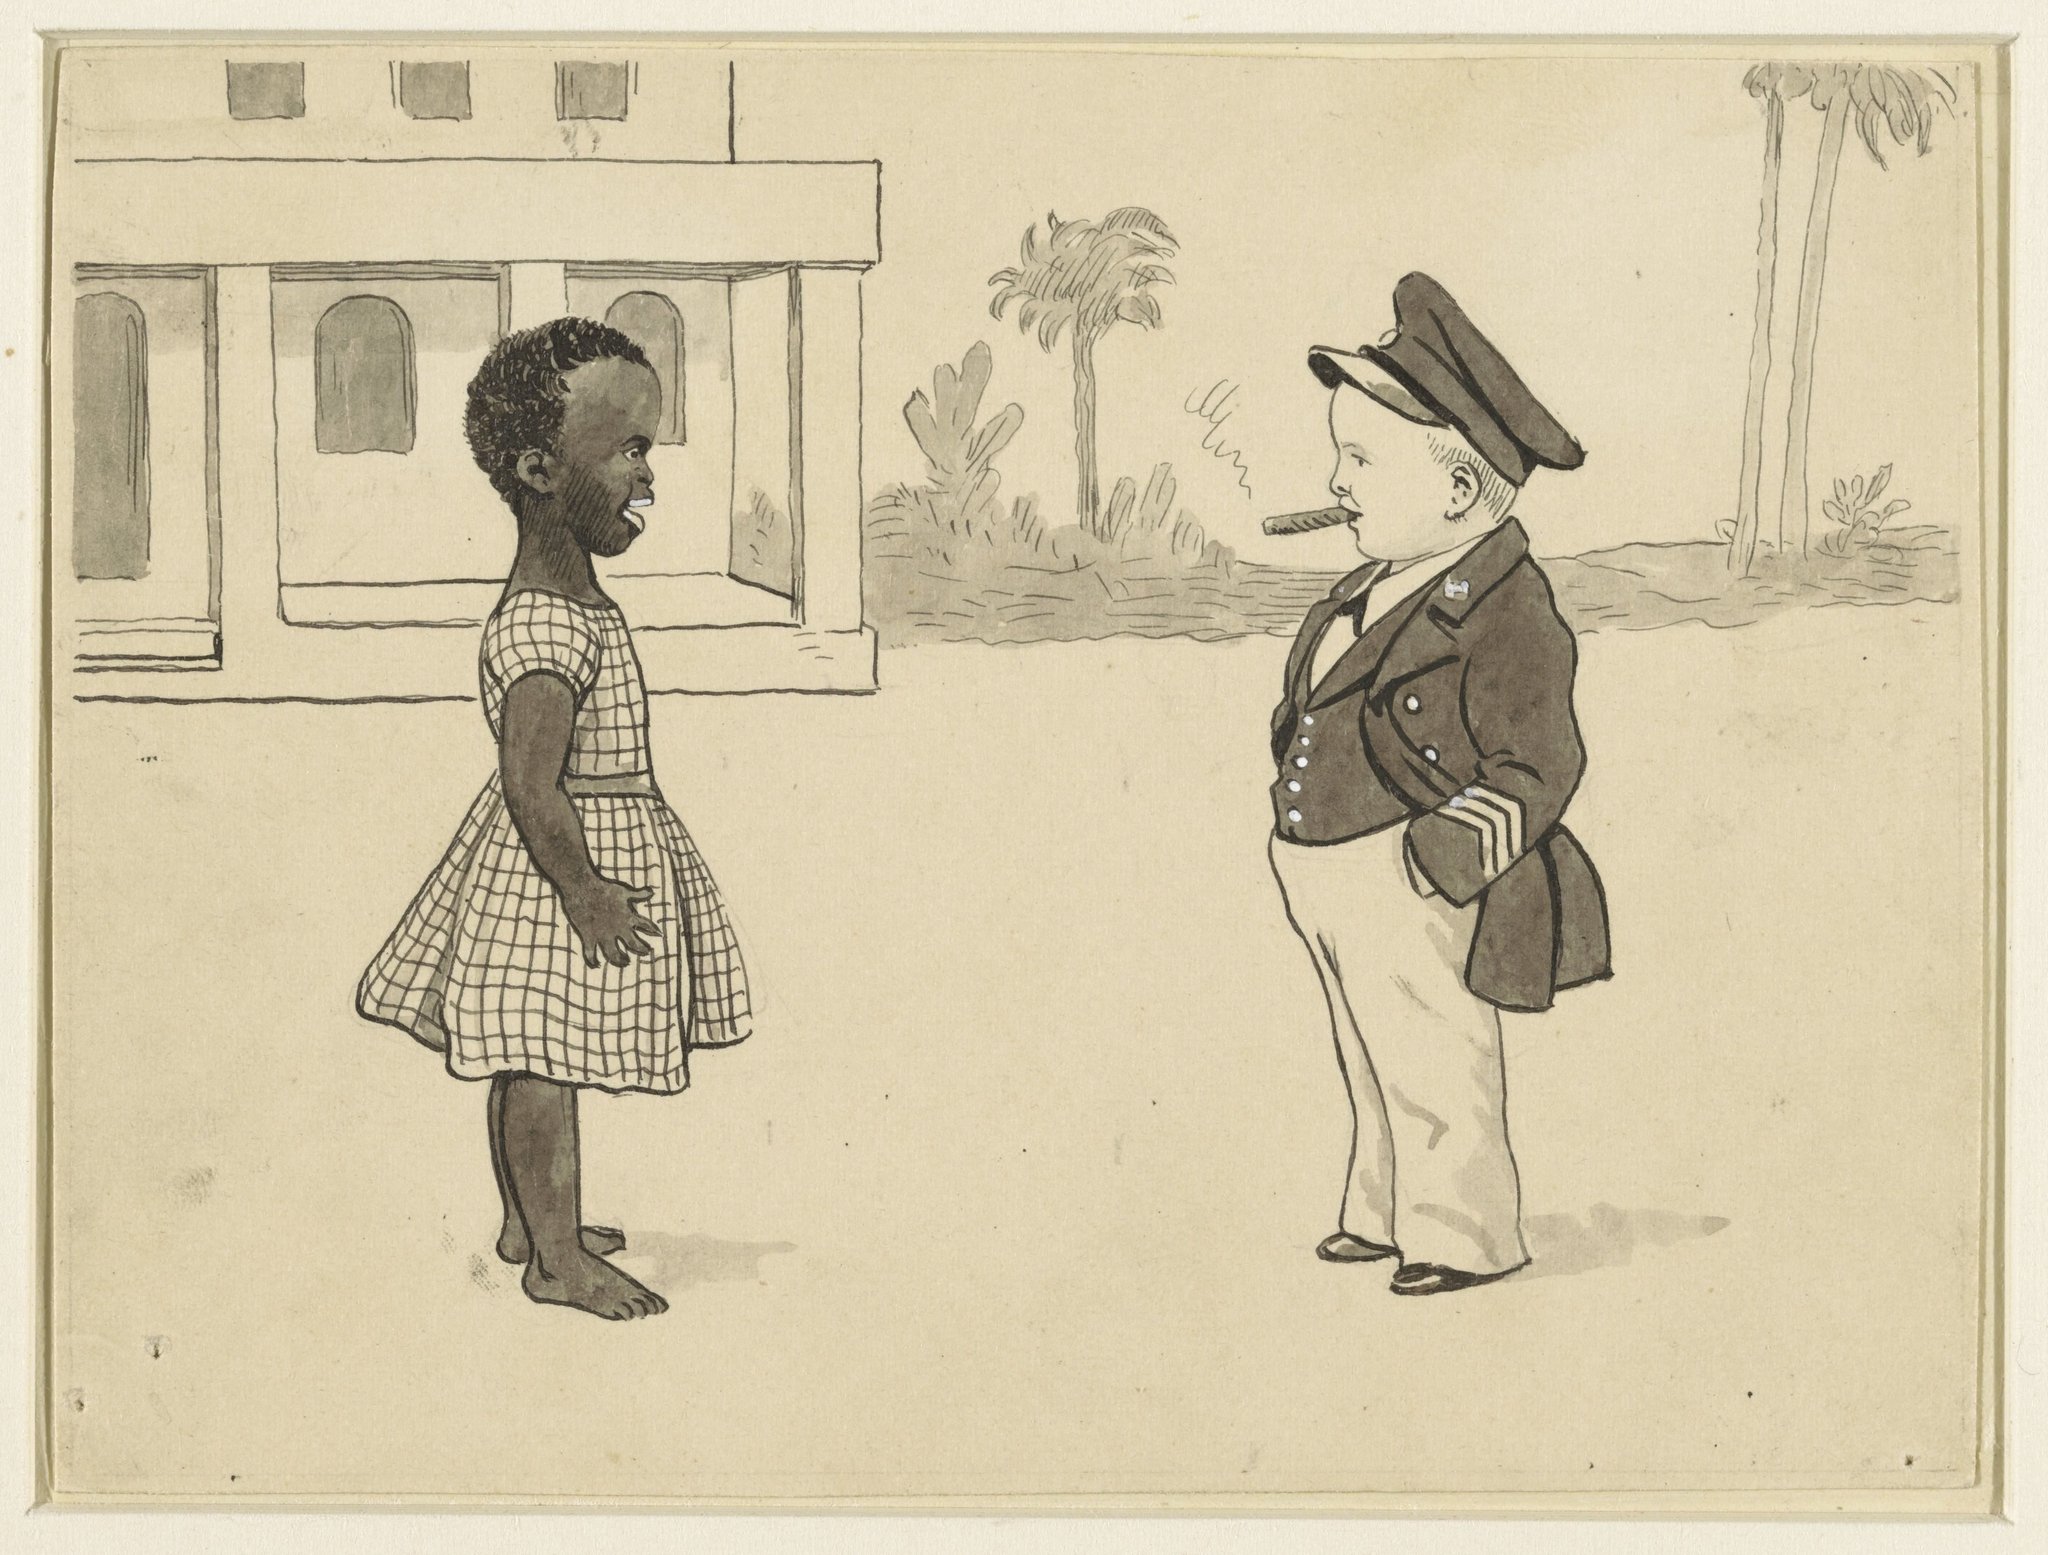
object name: drawing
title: West-Indië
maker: alfred michael roedstad schmidt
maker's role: draughtsman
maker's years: 1858-1938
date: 1868-1907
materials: ink, paper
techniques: brush, pen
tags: cigar, boy (child between toddler and youth), girl (child between toddler and youth)